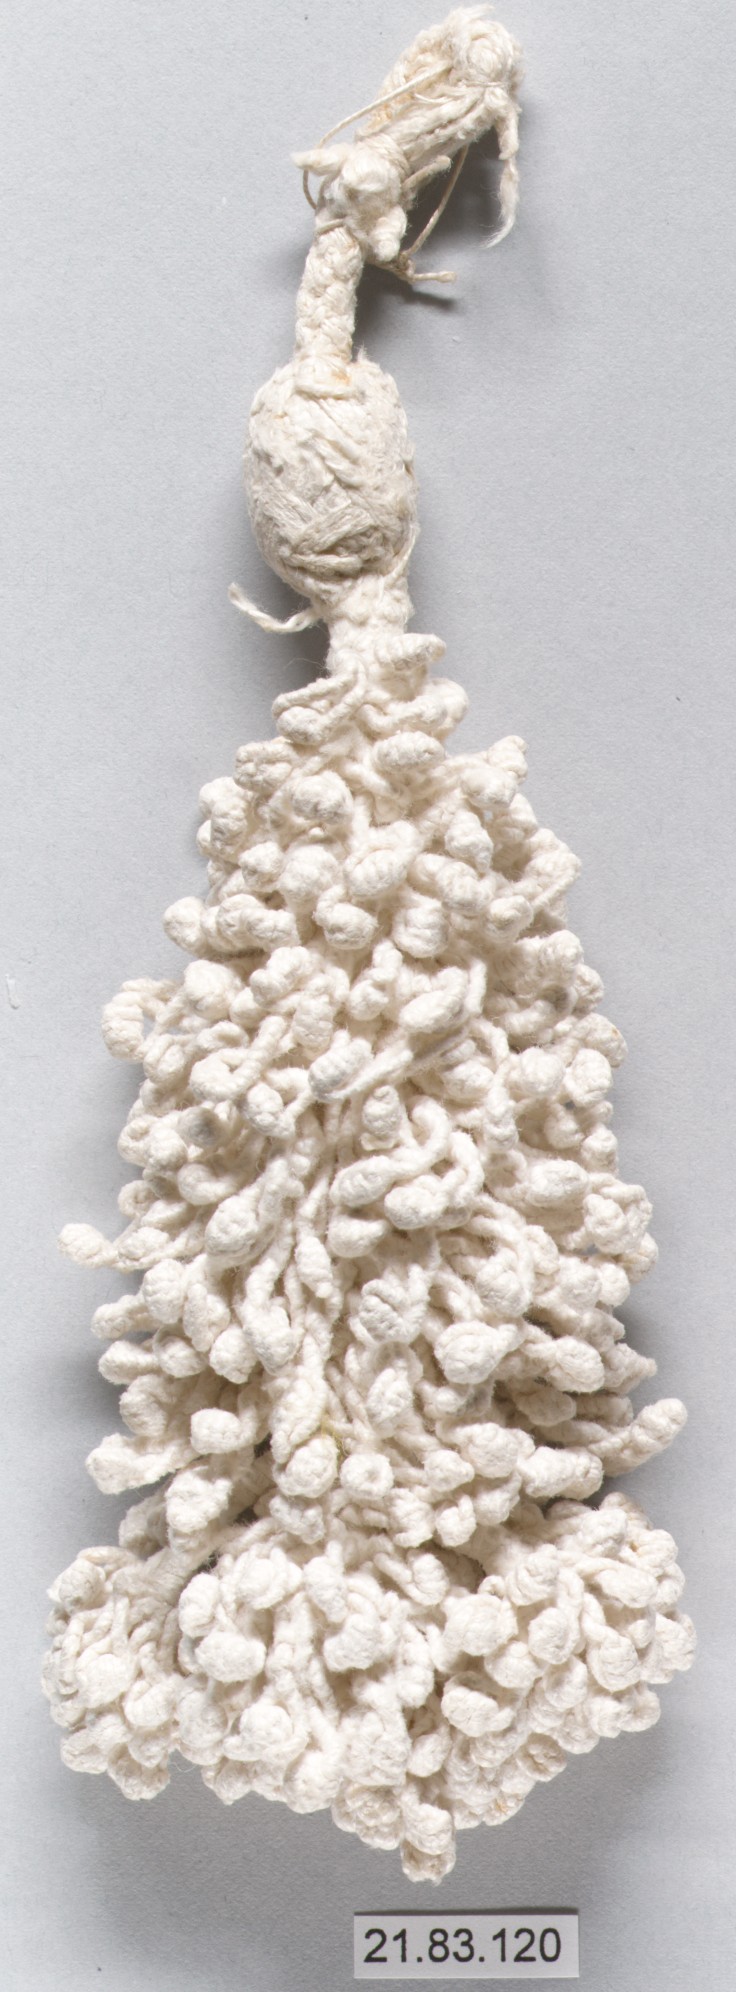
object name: tassel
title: Pair of tassels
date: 1601-1700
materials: linen